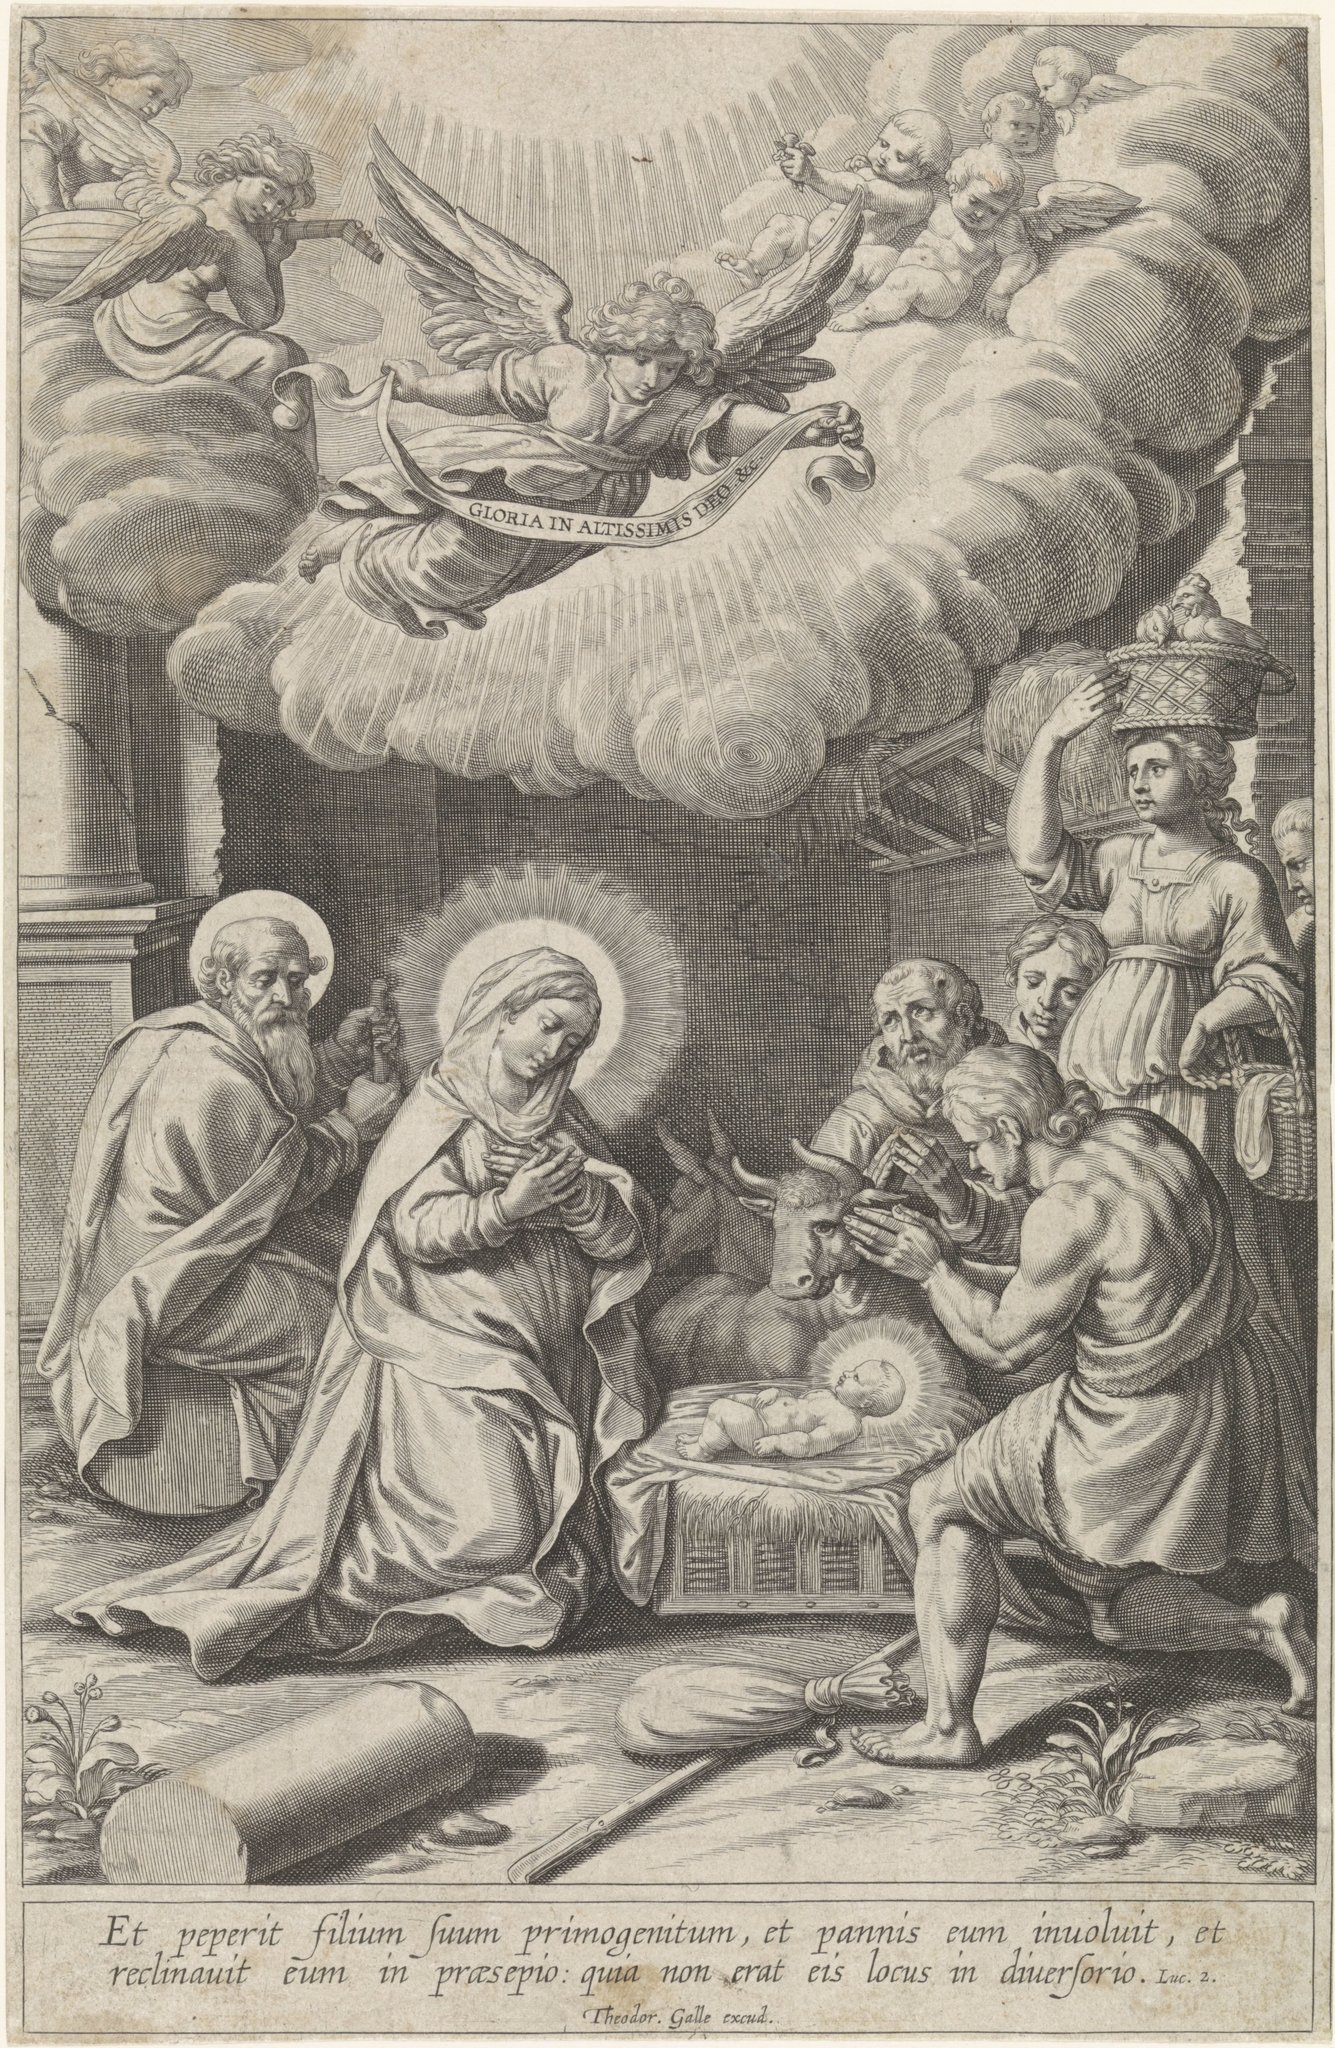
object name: print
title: Aanbidding door de herders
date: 1590-1637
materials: paper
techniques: engraving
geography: antwerp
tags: adoration of the christ-child by the shepherds; mary and joseph present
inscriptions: collector's mark: Lugt 240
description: Maria knielt voor de kribbe, achter haar zit Jozef. De herders en hun vrouwen scharen zich in aanbidding rondom de kribbe met het Christuskind. Engelen kijken toe vanuit de hemel. Eén van hen houdt een banderol vast met een opschrift in het Latijn. In de marge een tweeregelig onderschrift uit Luc. in het Latijn.